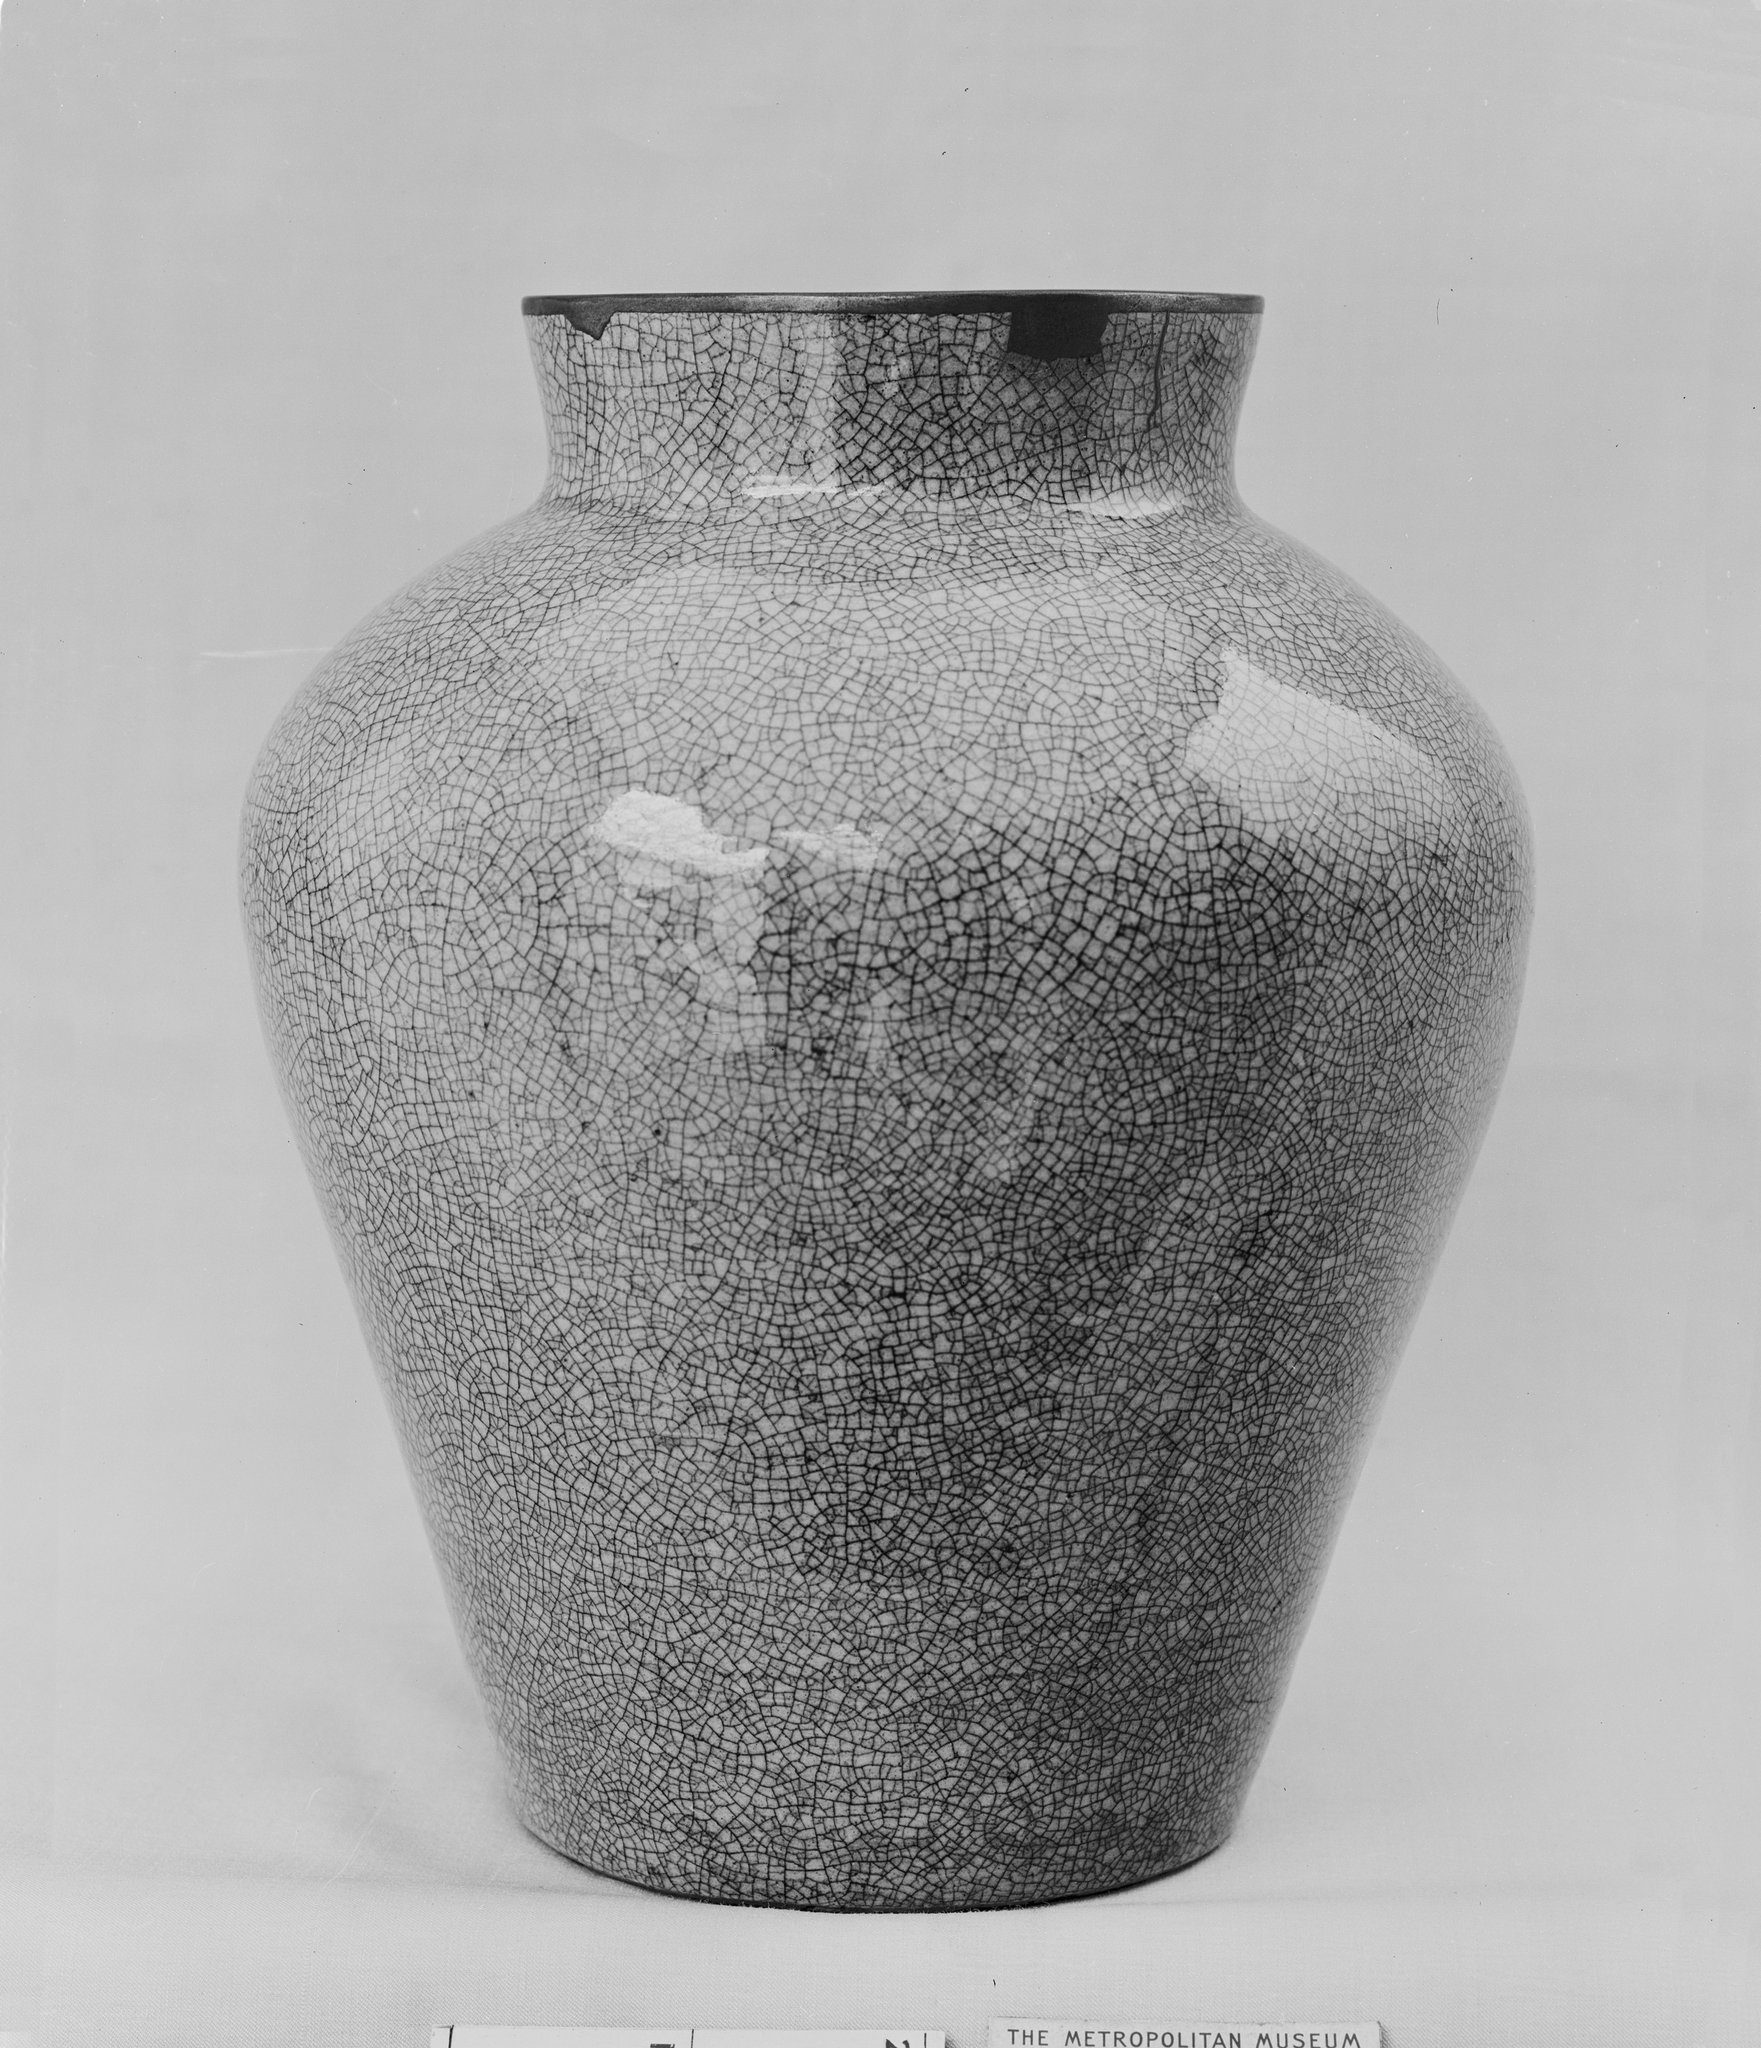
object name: jar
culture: japanese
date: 1801-1900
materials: clay, glaze